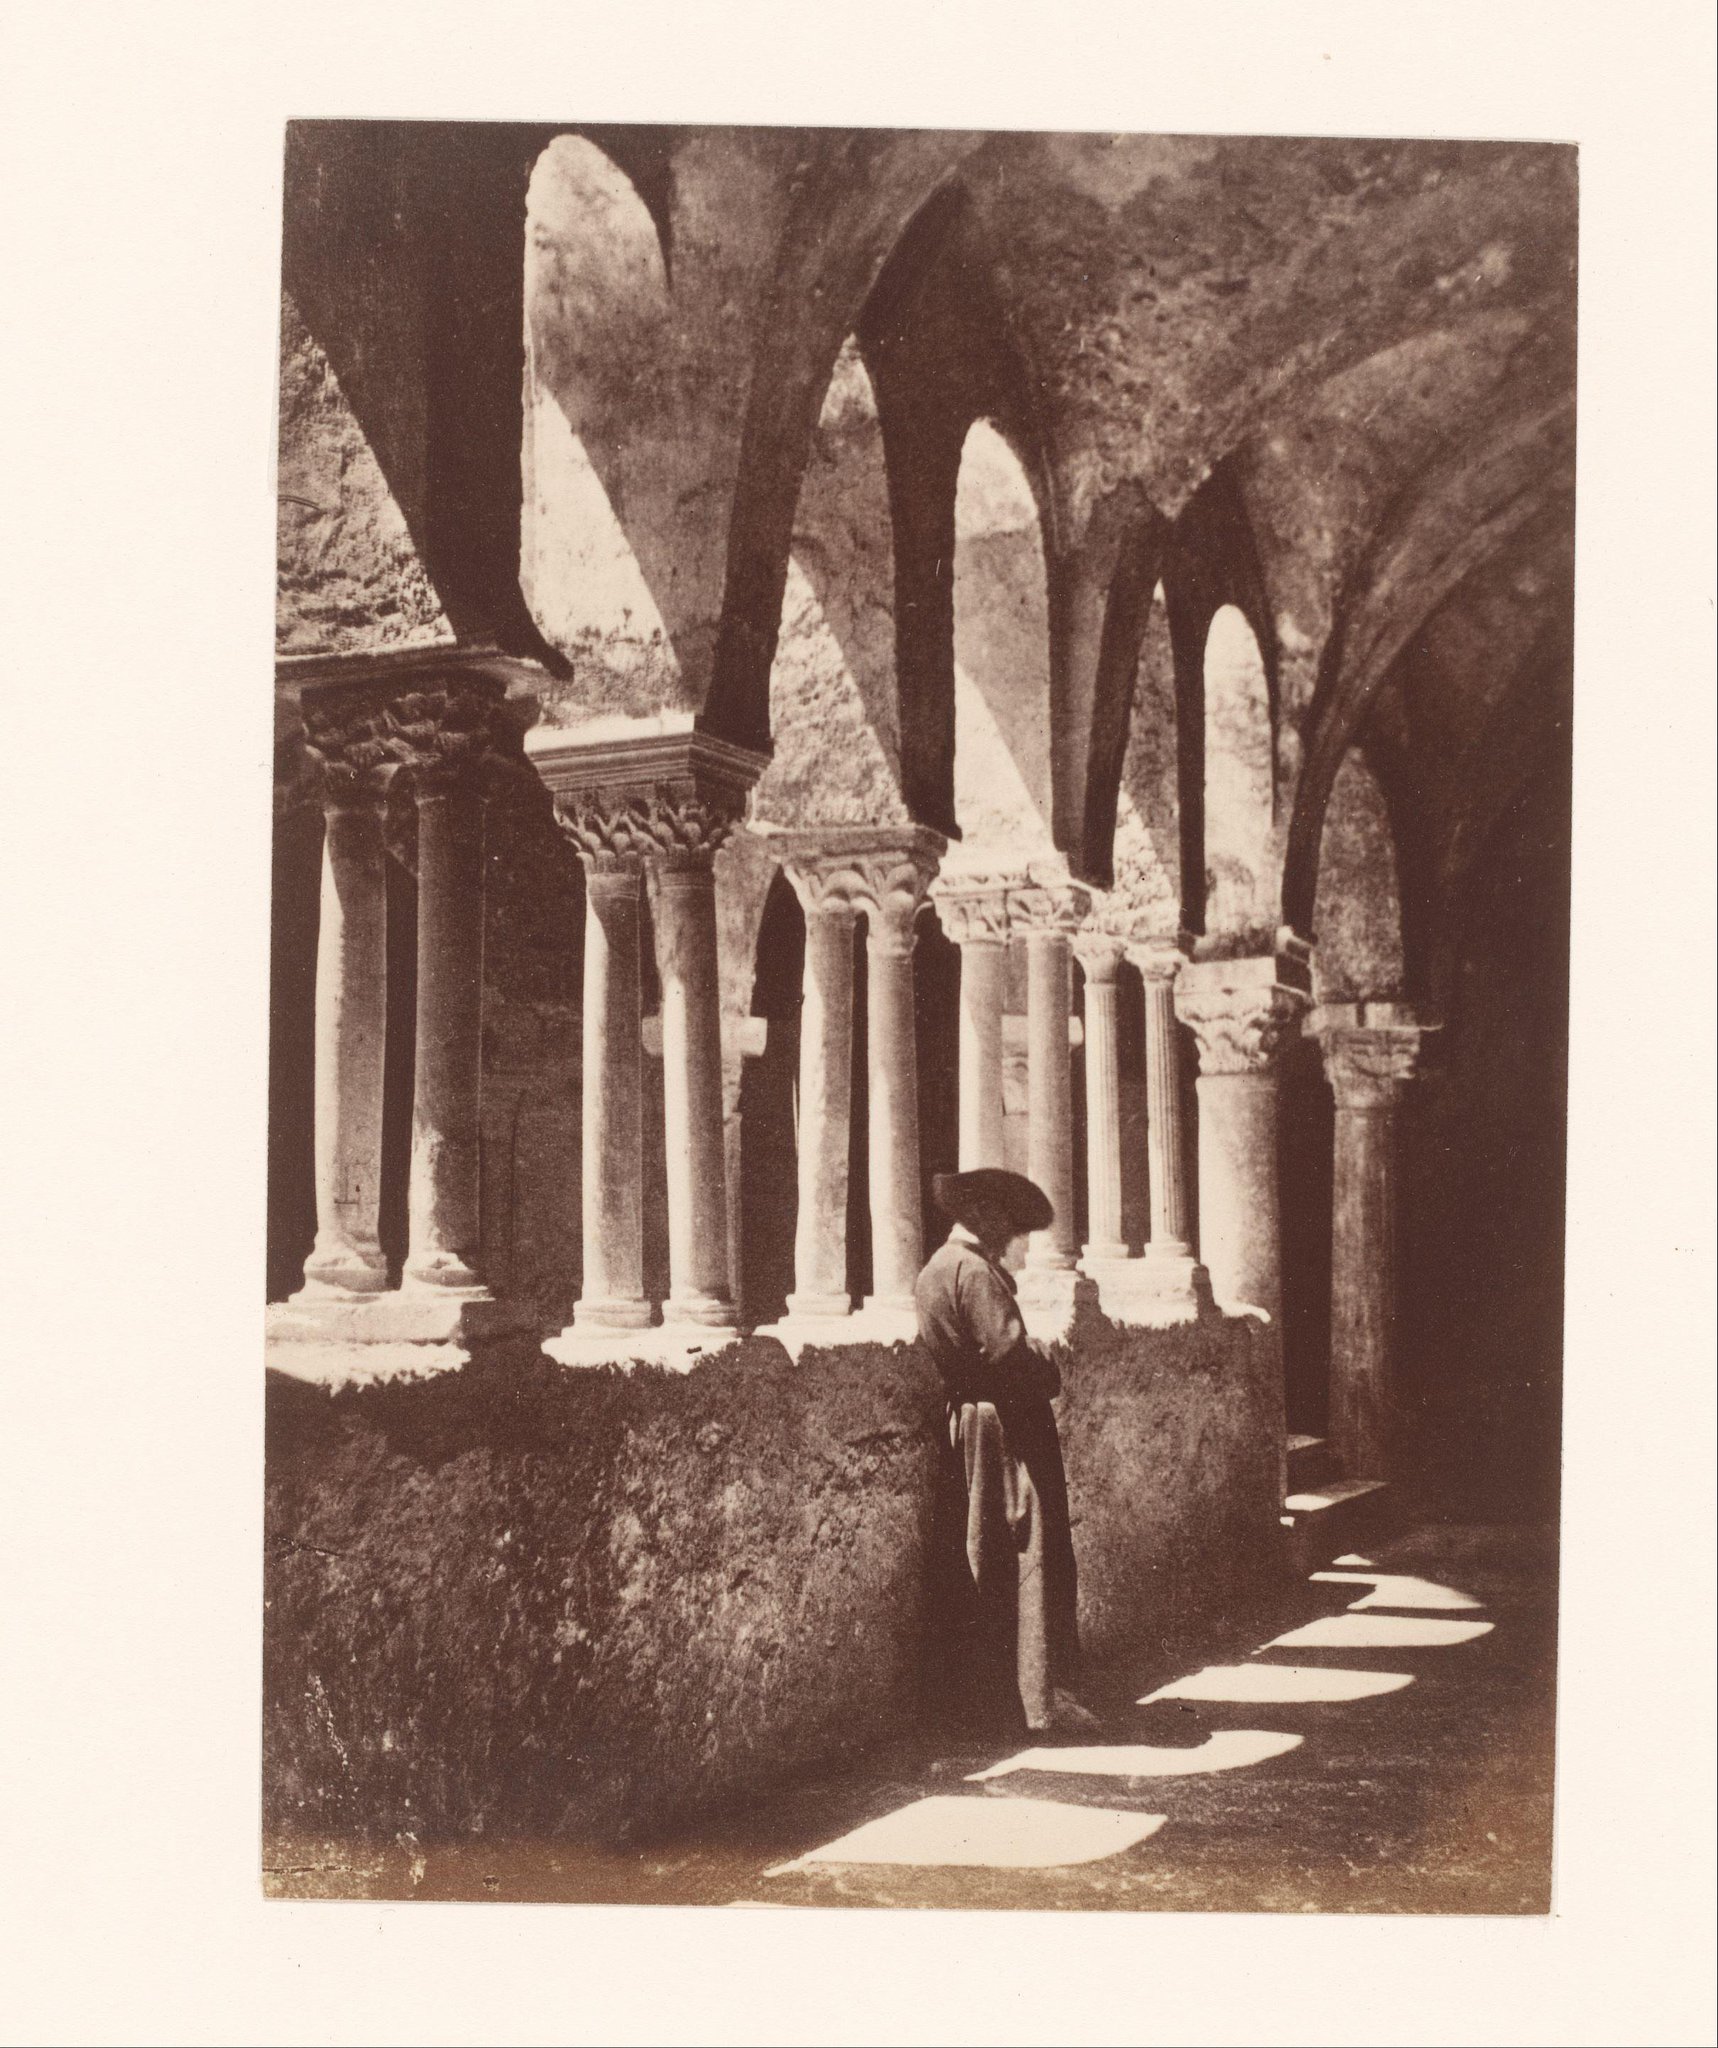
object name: photograph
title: Man in een kloostergang, mogelijk in Napels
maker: giorgio sommer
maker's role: fotograaf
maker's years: 1834-1914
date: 1857-1914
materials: paper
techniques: albumen print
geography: naples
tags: abbey, monastery, convent ~ roman catholic church, monk(s), friar(s), cloisters ~ monastery